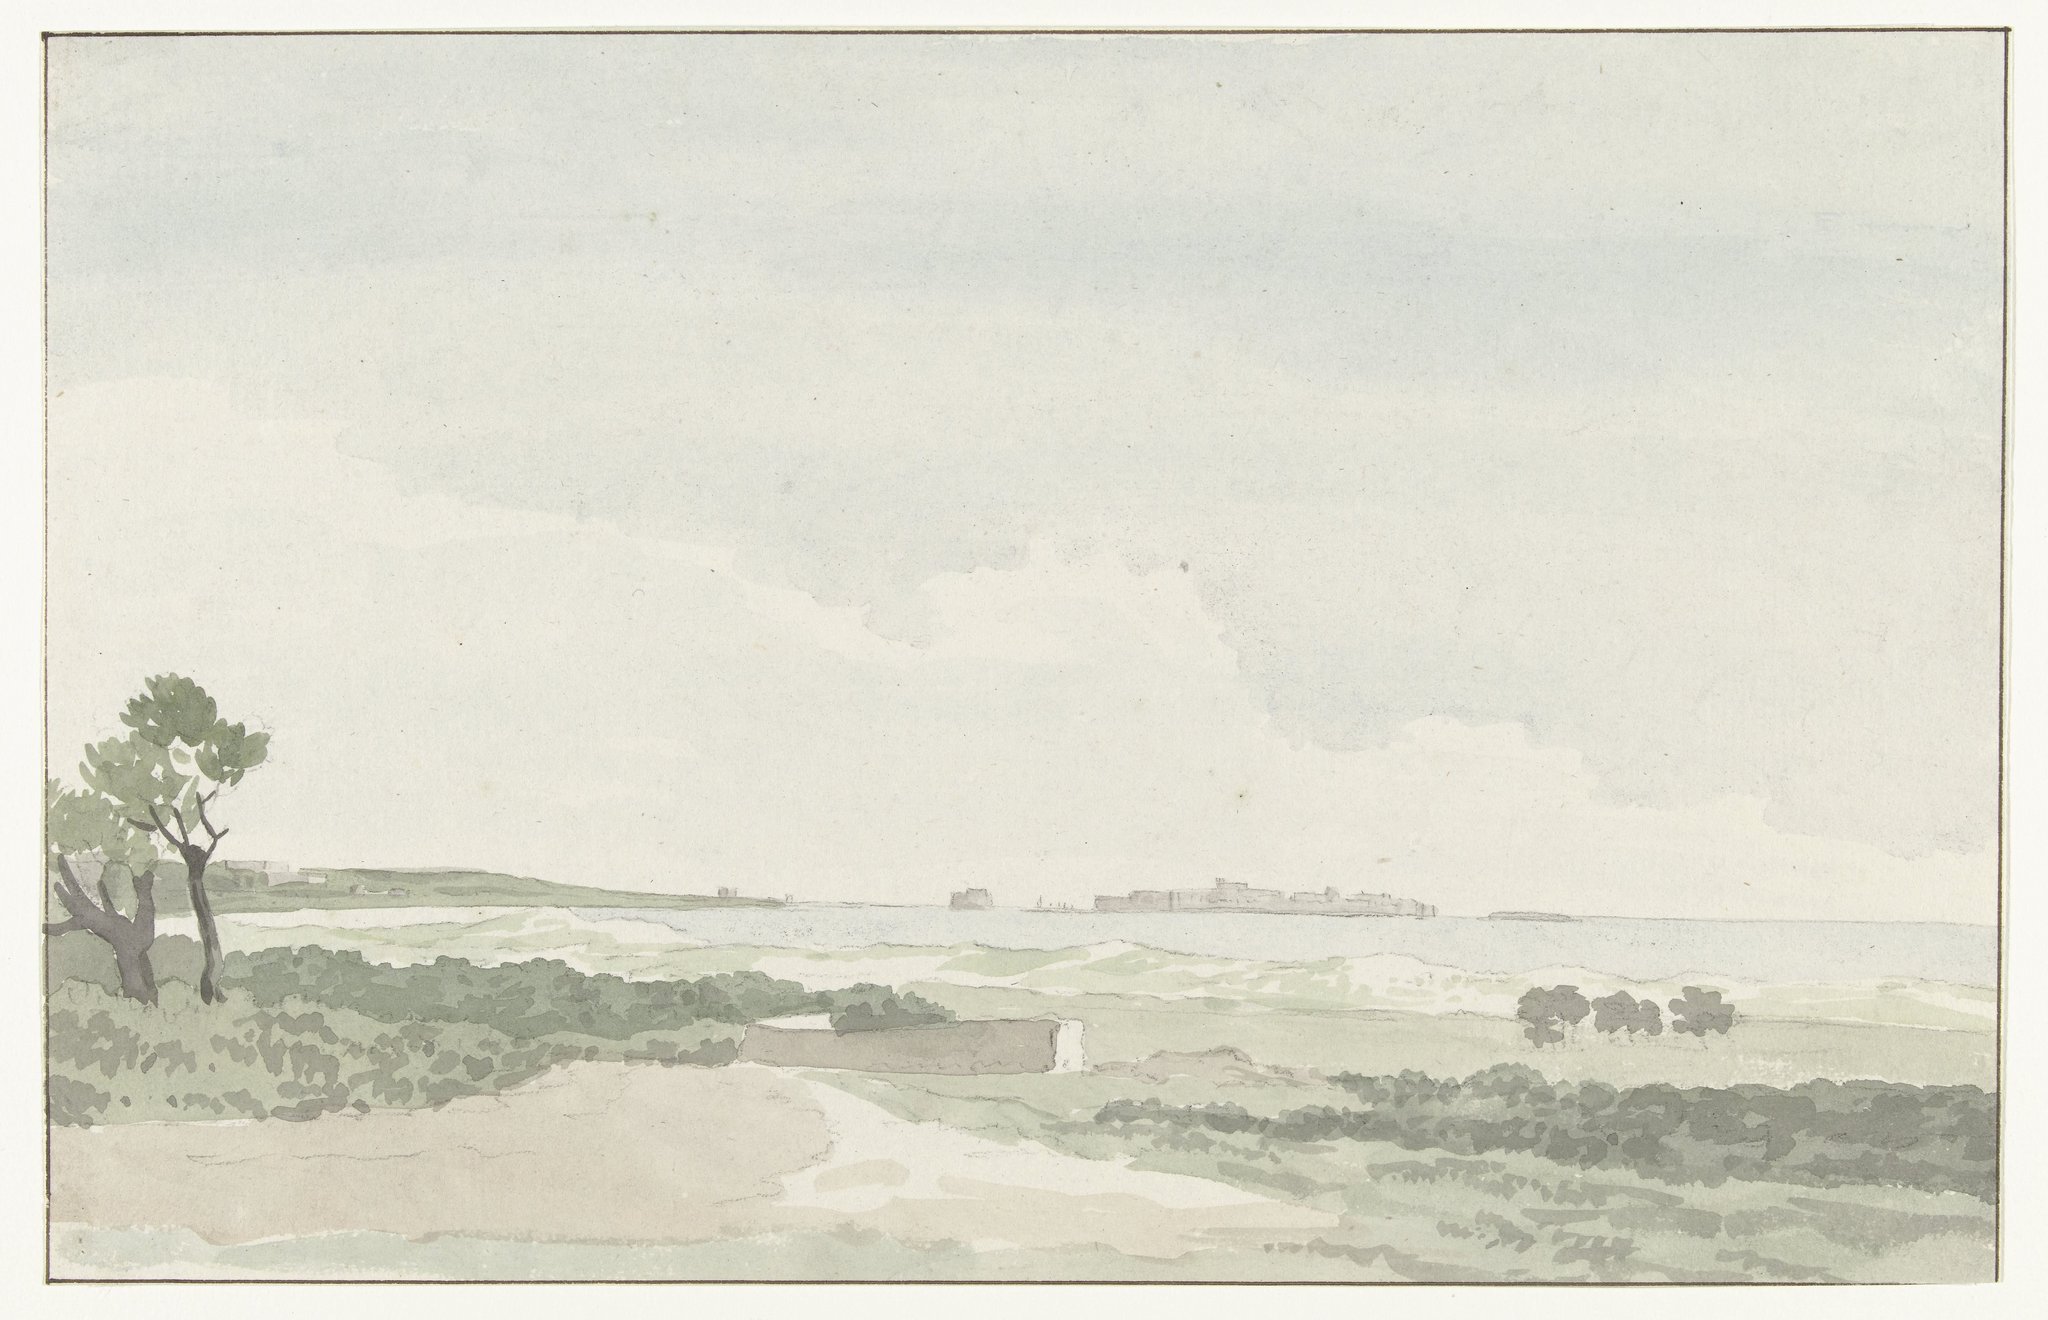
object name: drawing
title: Voyage en Italie, en Sicile et à Malte - 1778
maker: louis ducros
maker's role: draughtsman, print maker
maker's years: 1748-1810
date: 1778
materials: chalk, paper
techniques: brush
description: Tekening uit het album 'Voyage en Italie, en Sicile et à Malte', 1778.